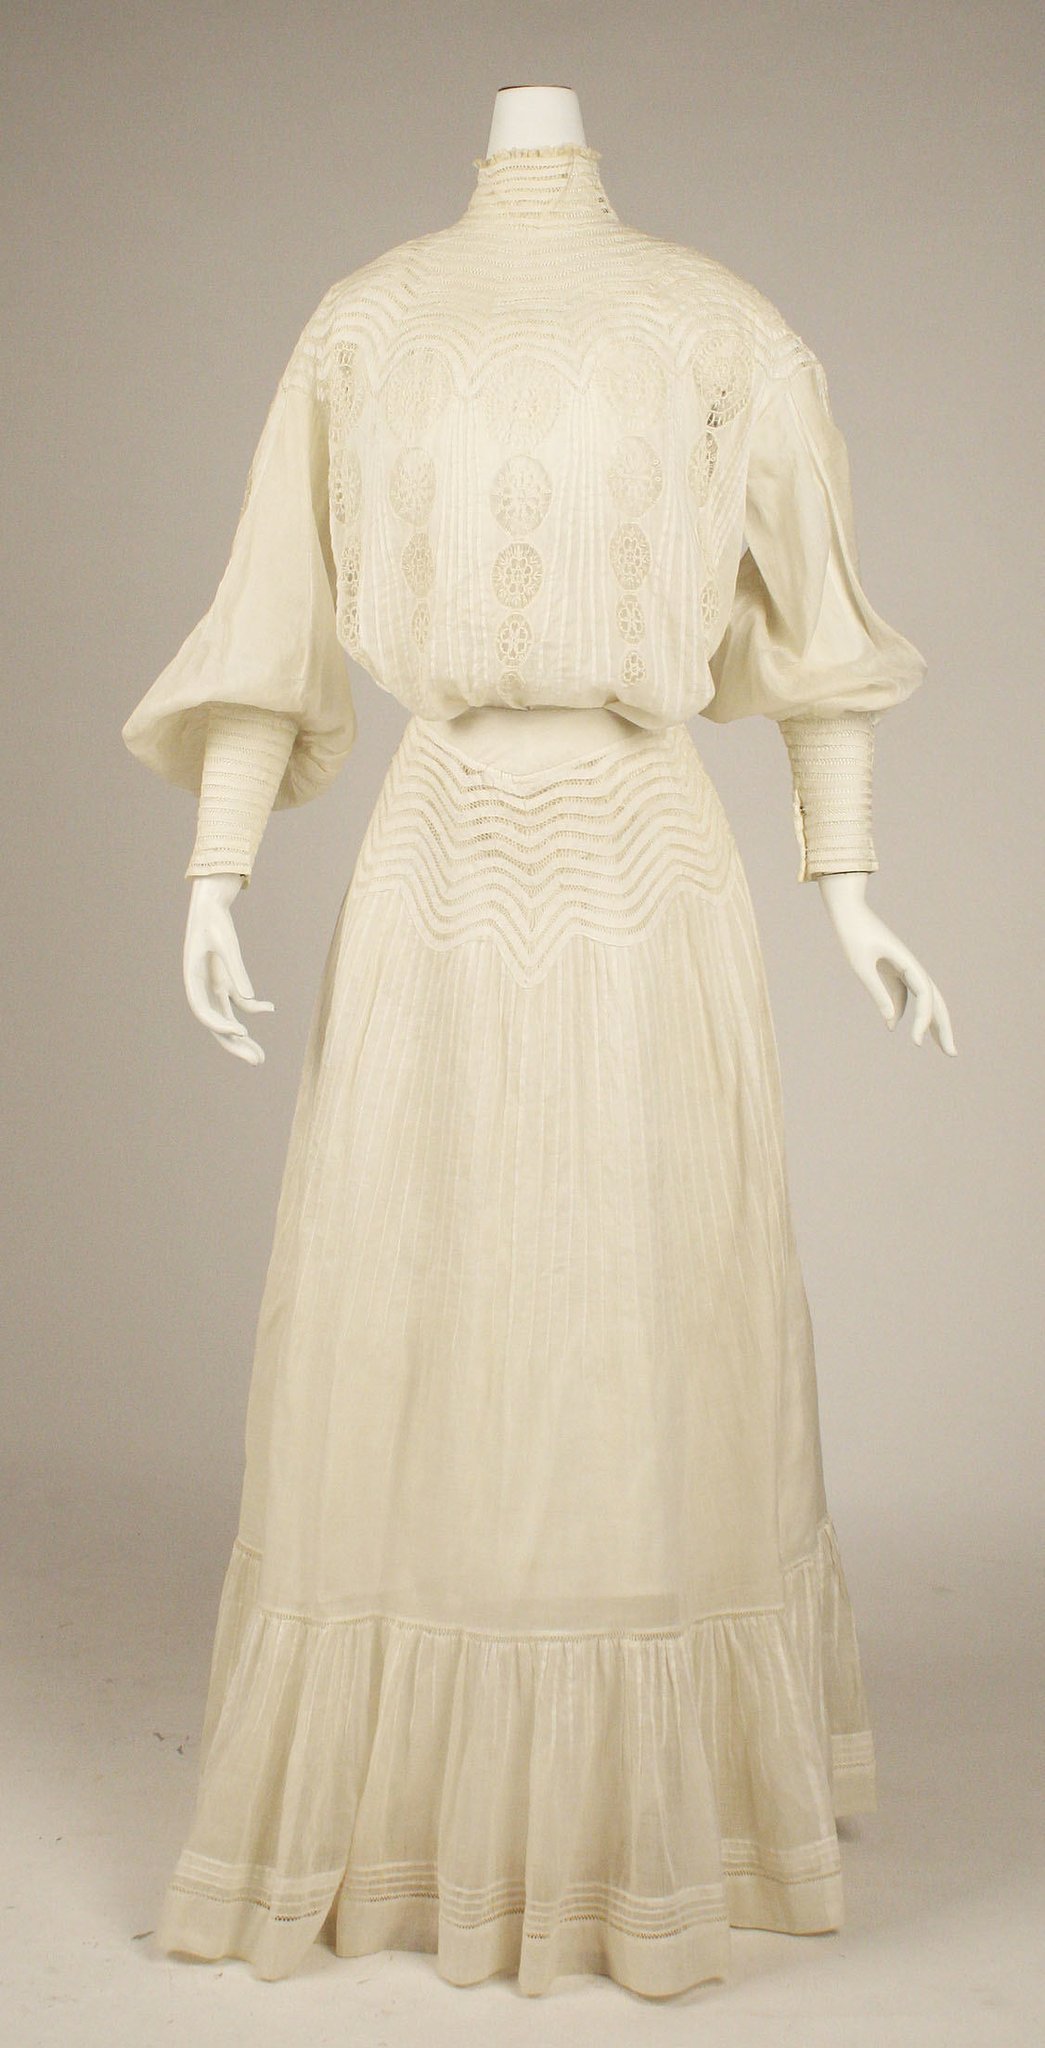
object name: dress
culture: american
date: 1903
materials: cotton